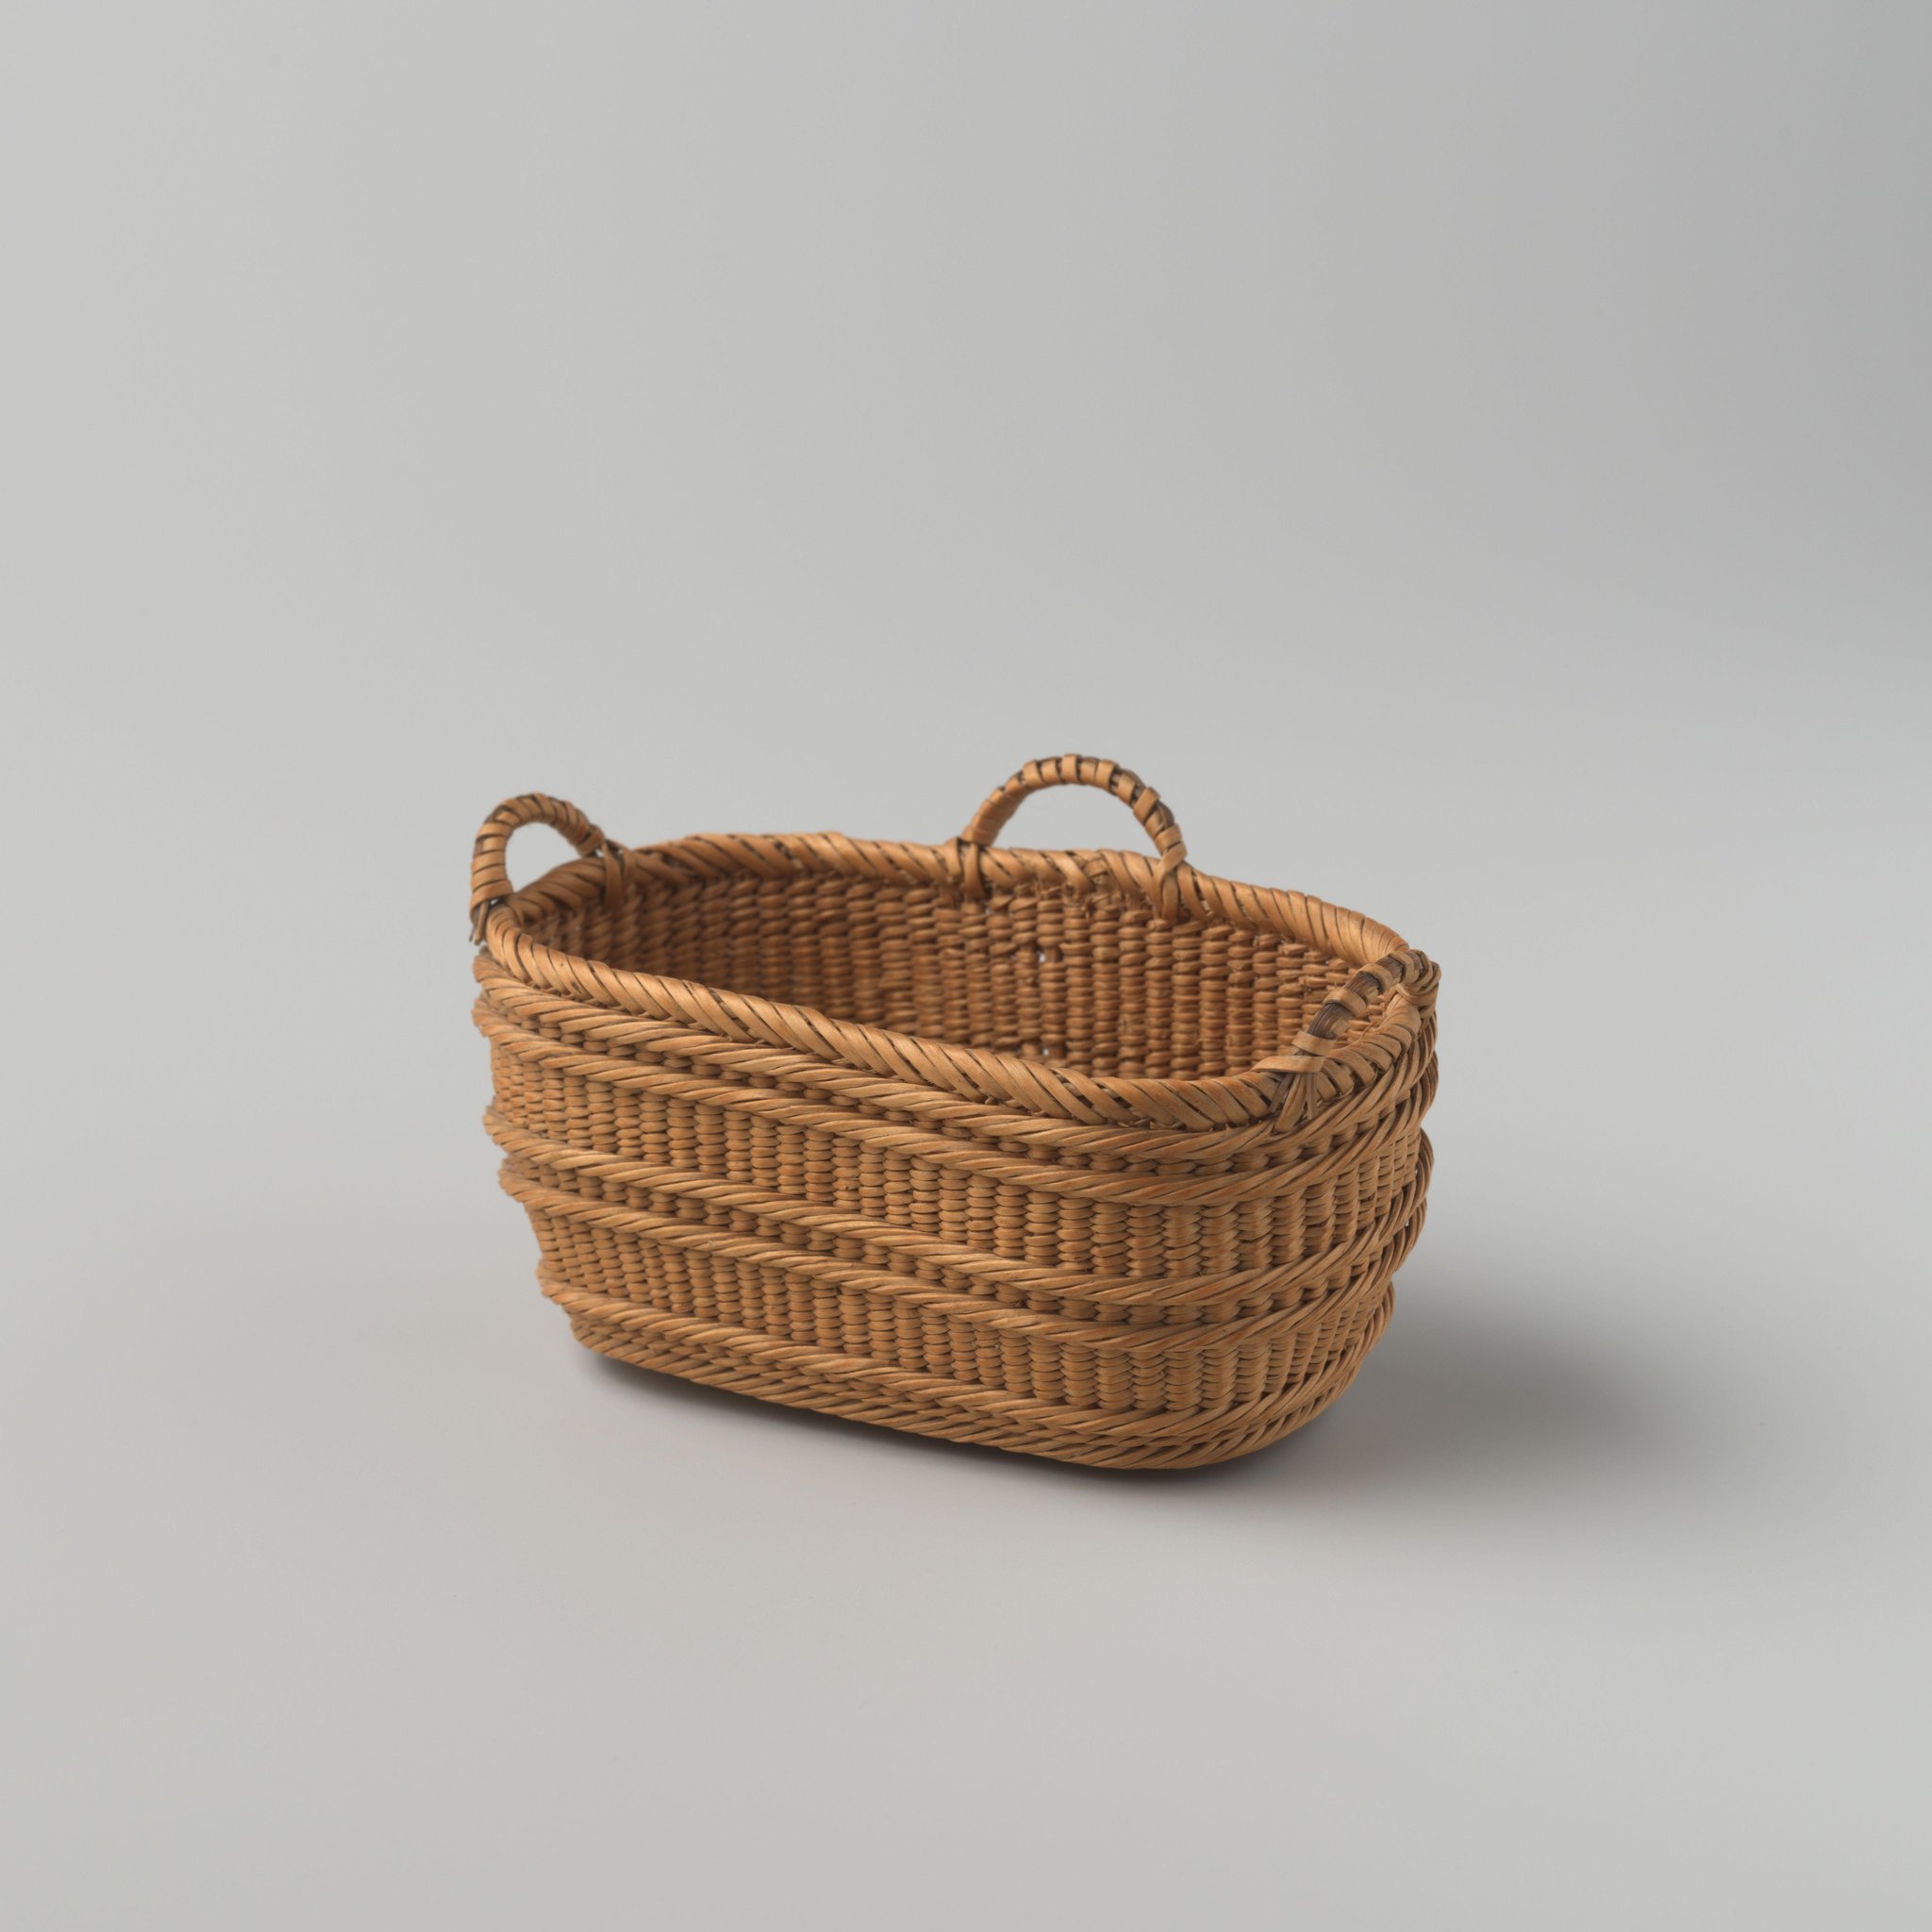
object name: basket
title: Ovale mand van gespleten wilgenteen, fijnscheenwerk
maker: Anonymous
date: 1690-1710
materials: hair, plant material, silk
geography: halle